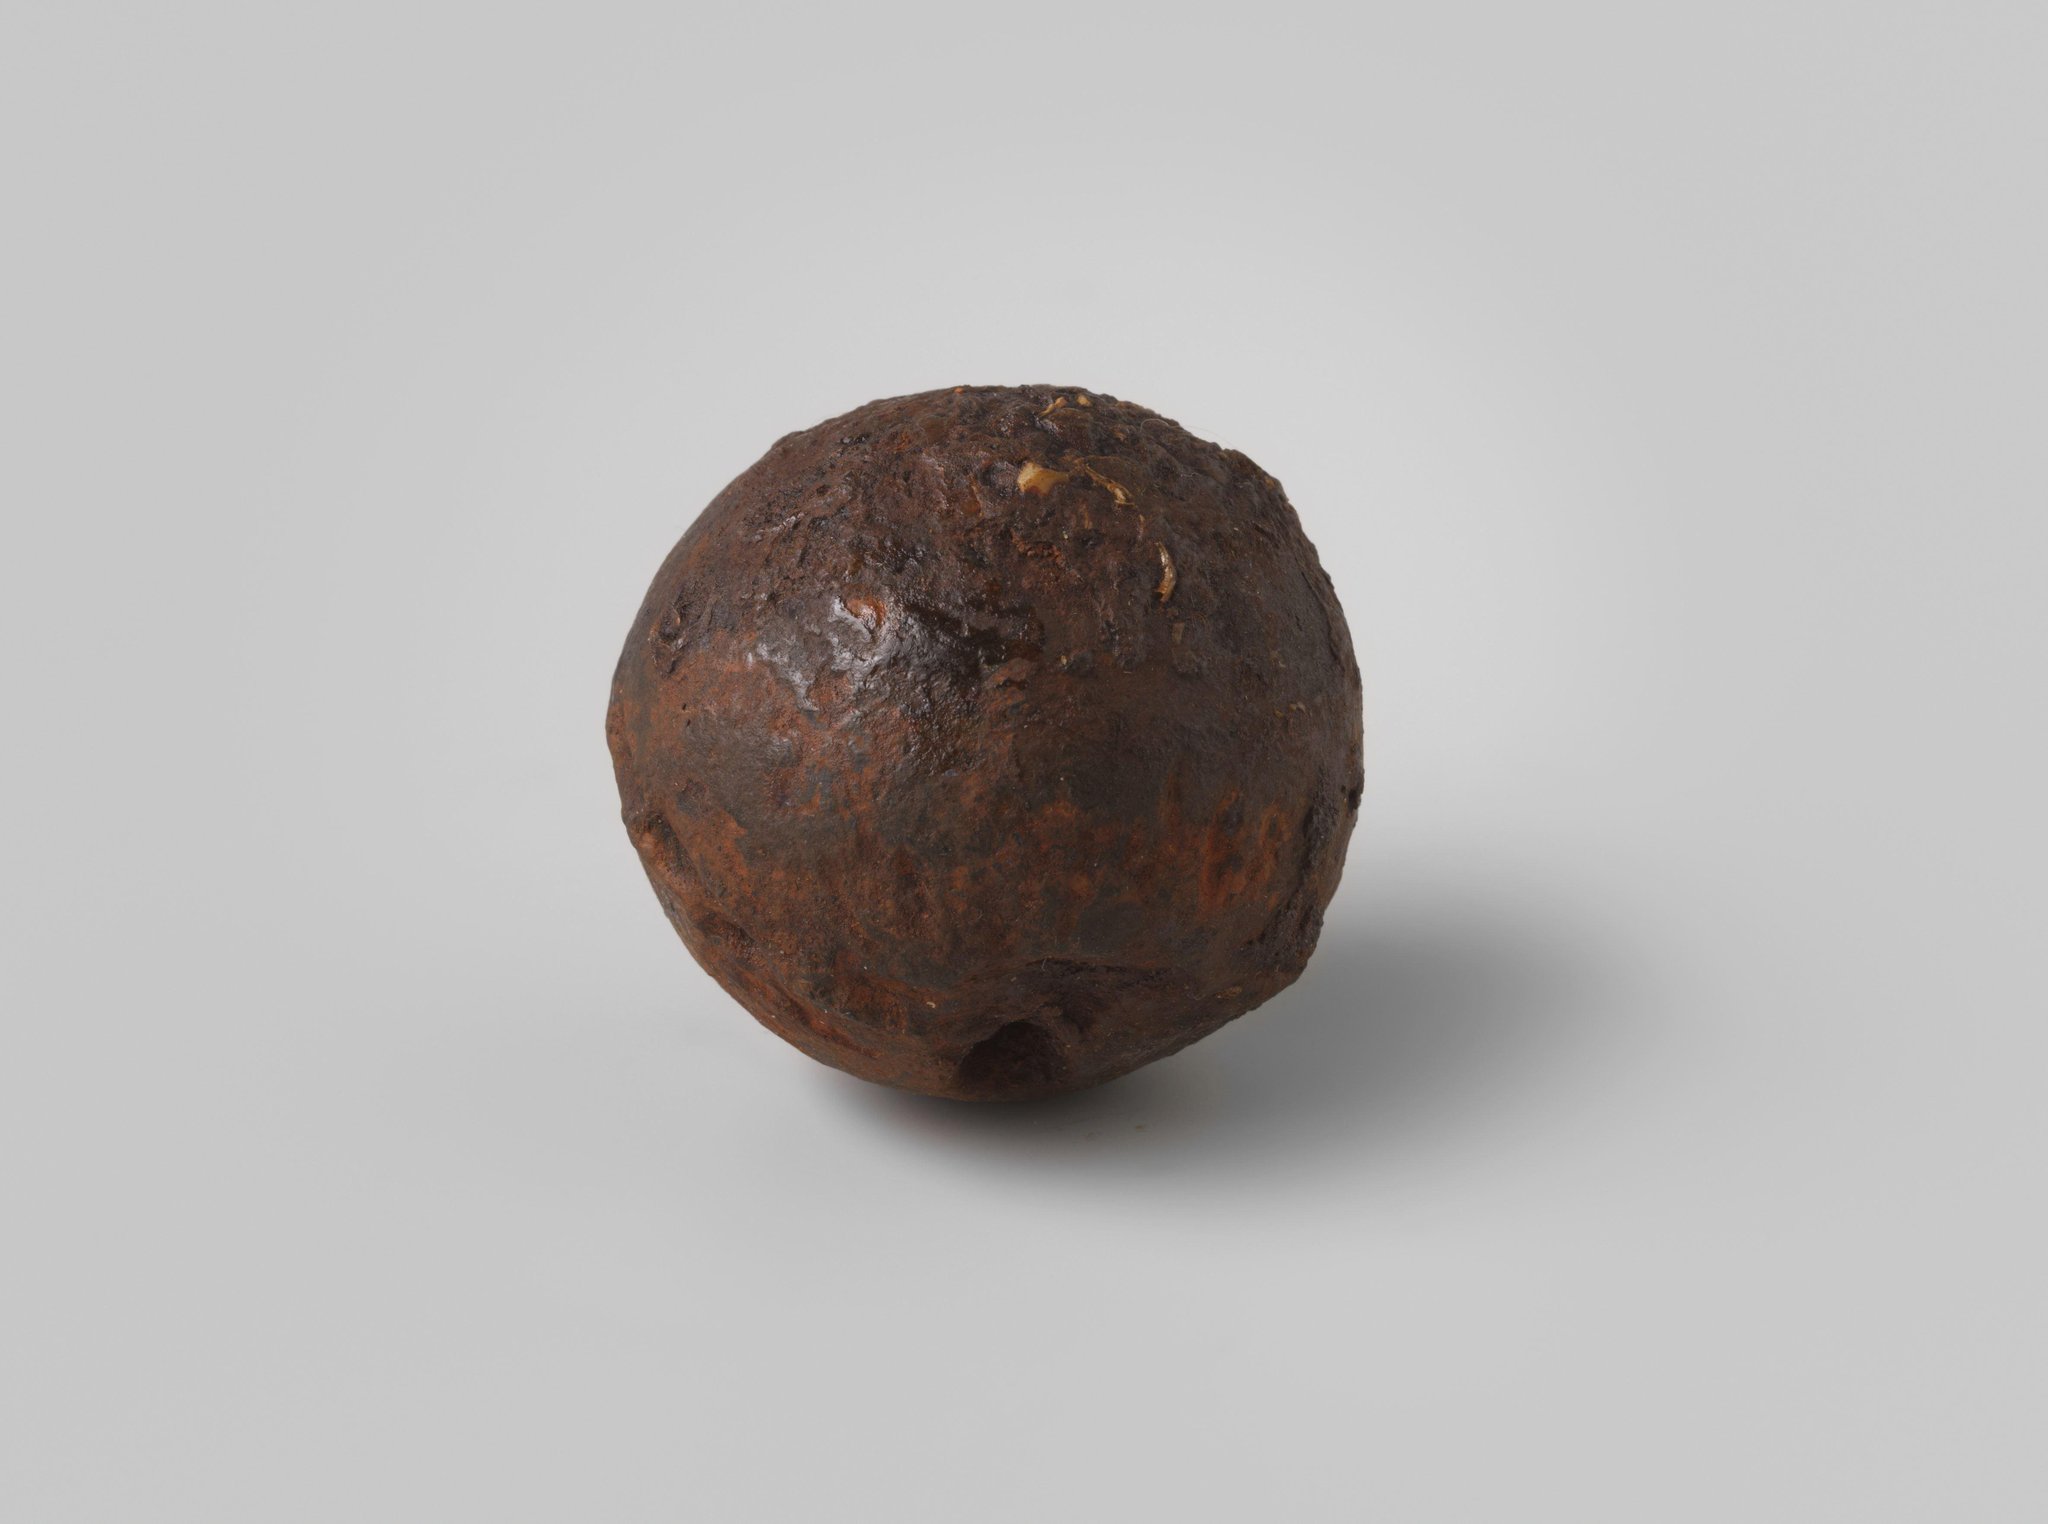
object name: bullet ammunition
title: Kogel uit het wrak van de Oost-Indiëvaarder Hollandia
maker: Anonymous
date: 1700-1743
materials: iron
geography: netherlands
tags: verenigde oostindische compagnie, hollandia (schip), annet